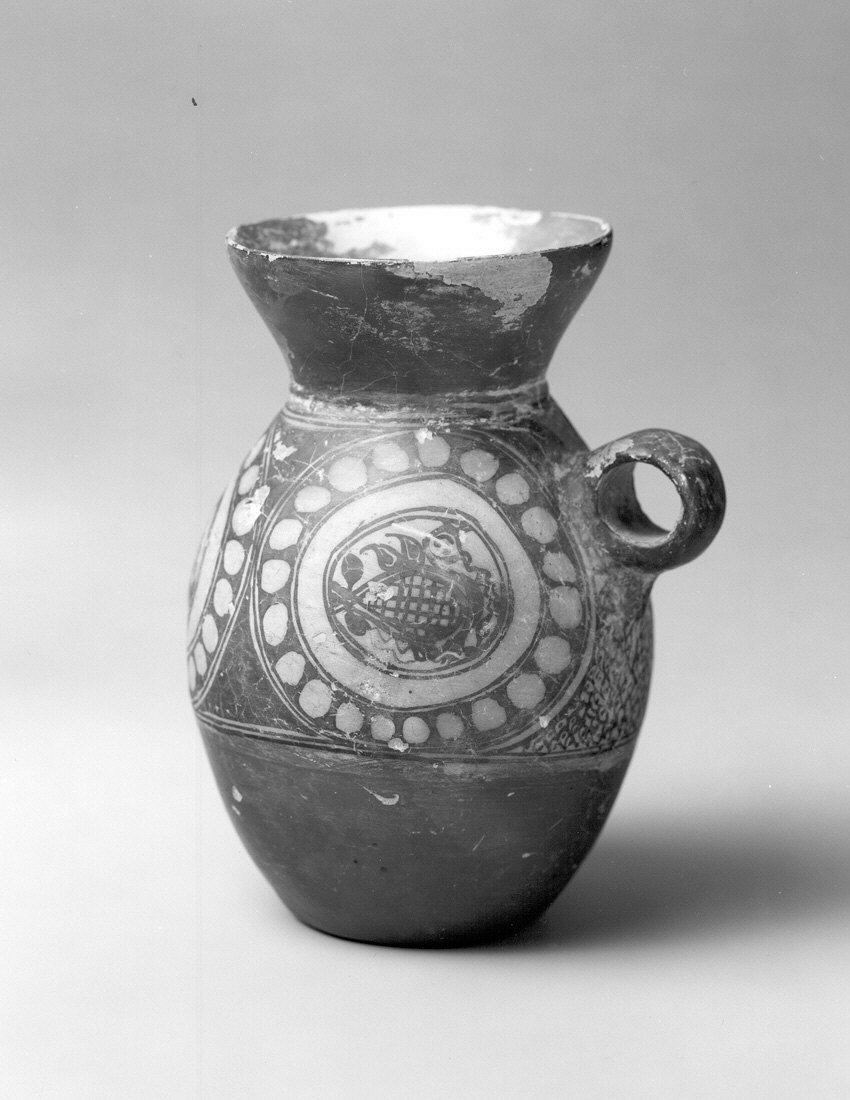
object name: vessel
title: Vessel decorated with birds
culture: western central asian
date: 701-900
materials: ceramic, paint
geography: western central asia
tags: birds